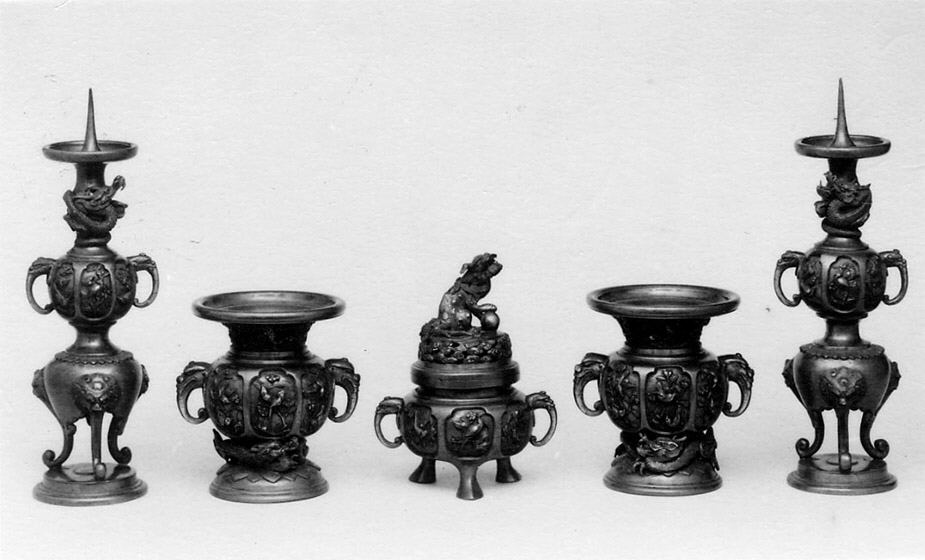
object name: votive implement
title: Three Votive Implements: Incense Burner, Candlestick, and Vase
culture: japanese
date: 1801-1900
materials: bronze